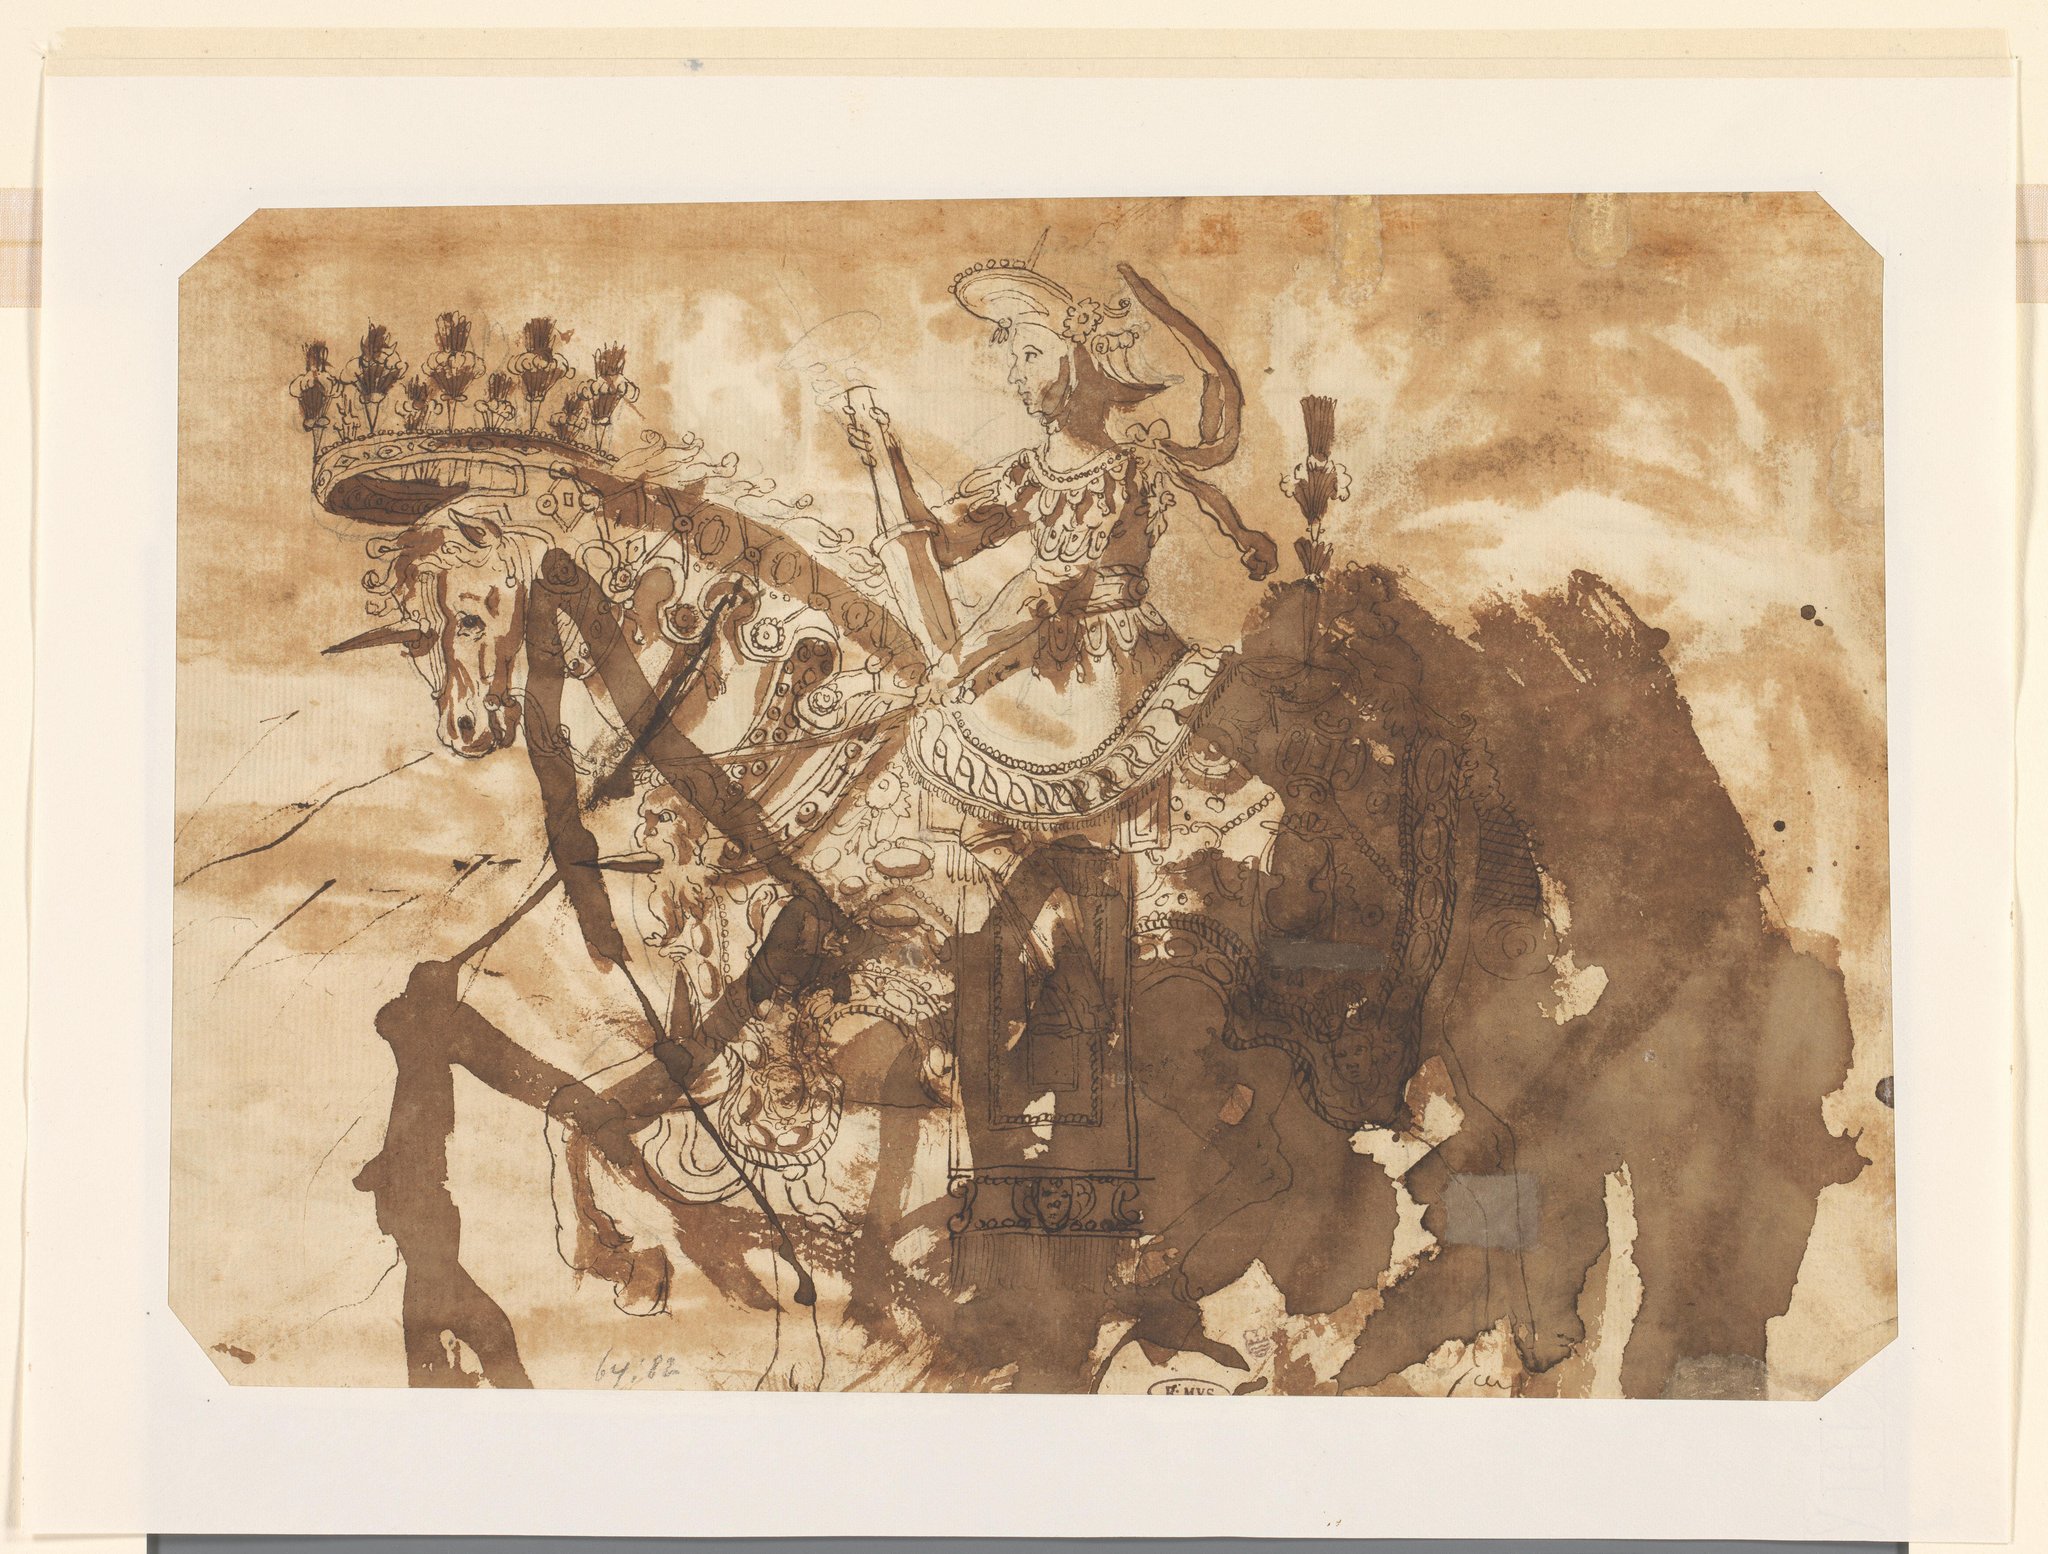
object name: drawing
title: Vrouw met lans te paard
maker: domenico tintoretto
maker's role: draughtsman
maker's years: 1560-1635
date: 1570-1635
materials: ink, paper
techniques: brush, pen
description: Vrouw die een lans vasthoudt op rijk getuigd paard met 16de-eeuwse schabrak.